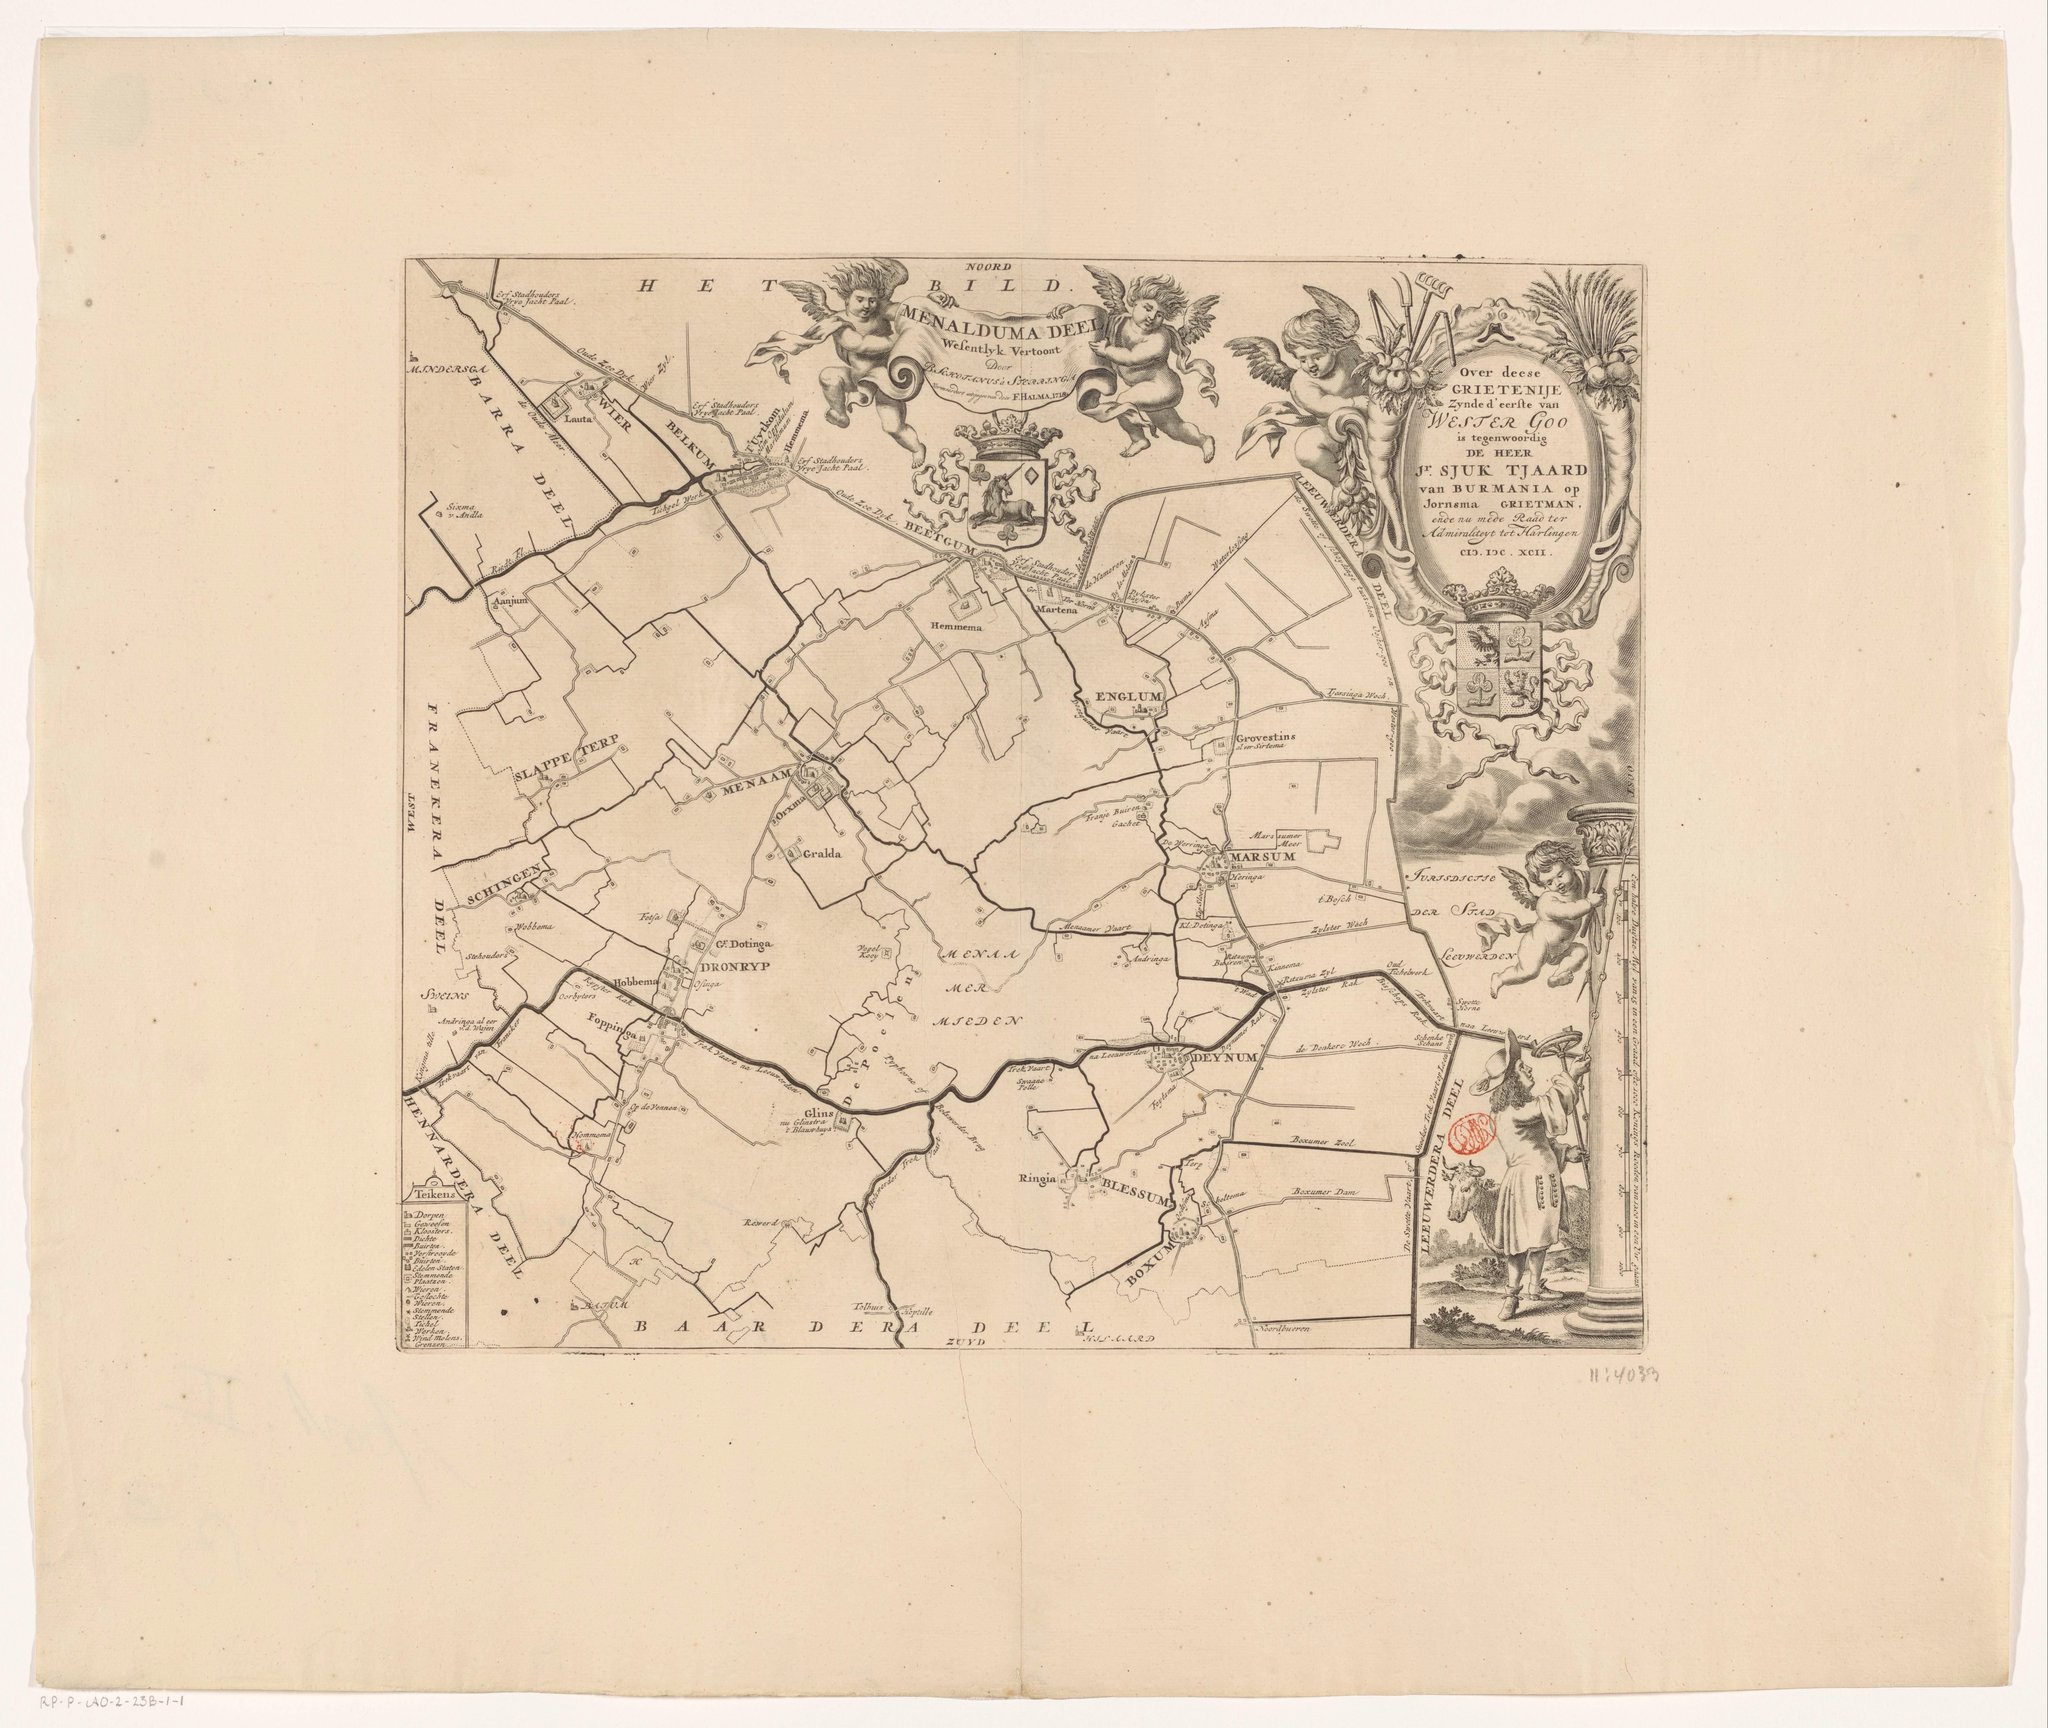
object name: map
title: Menalduma deel (...)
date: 1698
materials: paper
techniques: engraving, etching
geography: friesland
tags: coat of arms (as symbol of the state, etc.), maps of separate countries or regions, geodesy, surveying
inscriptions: collector's mark: Lugt 2228, collector's mark: Lugt 195, label: ‘264’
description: Linksonder legenda. Boven in het midden titelcartouche met daaronder het wapen van Menaldumadeel. Rechtsboven cartouche met bestuurlijke informatie over de grietenij, daaronder het wapen van grietman jonker Sjuk Tjaard van Burmania. Daaronder een zuil met een schaalstok: Een halve Duytze myl van 15 in een graad ofte 1000 konings roeden van 1200 in een uir gaans. Daaromheen een putto en een landmeter met meetgereedschap.